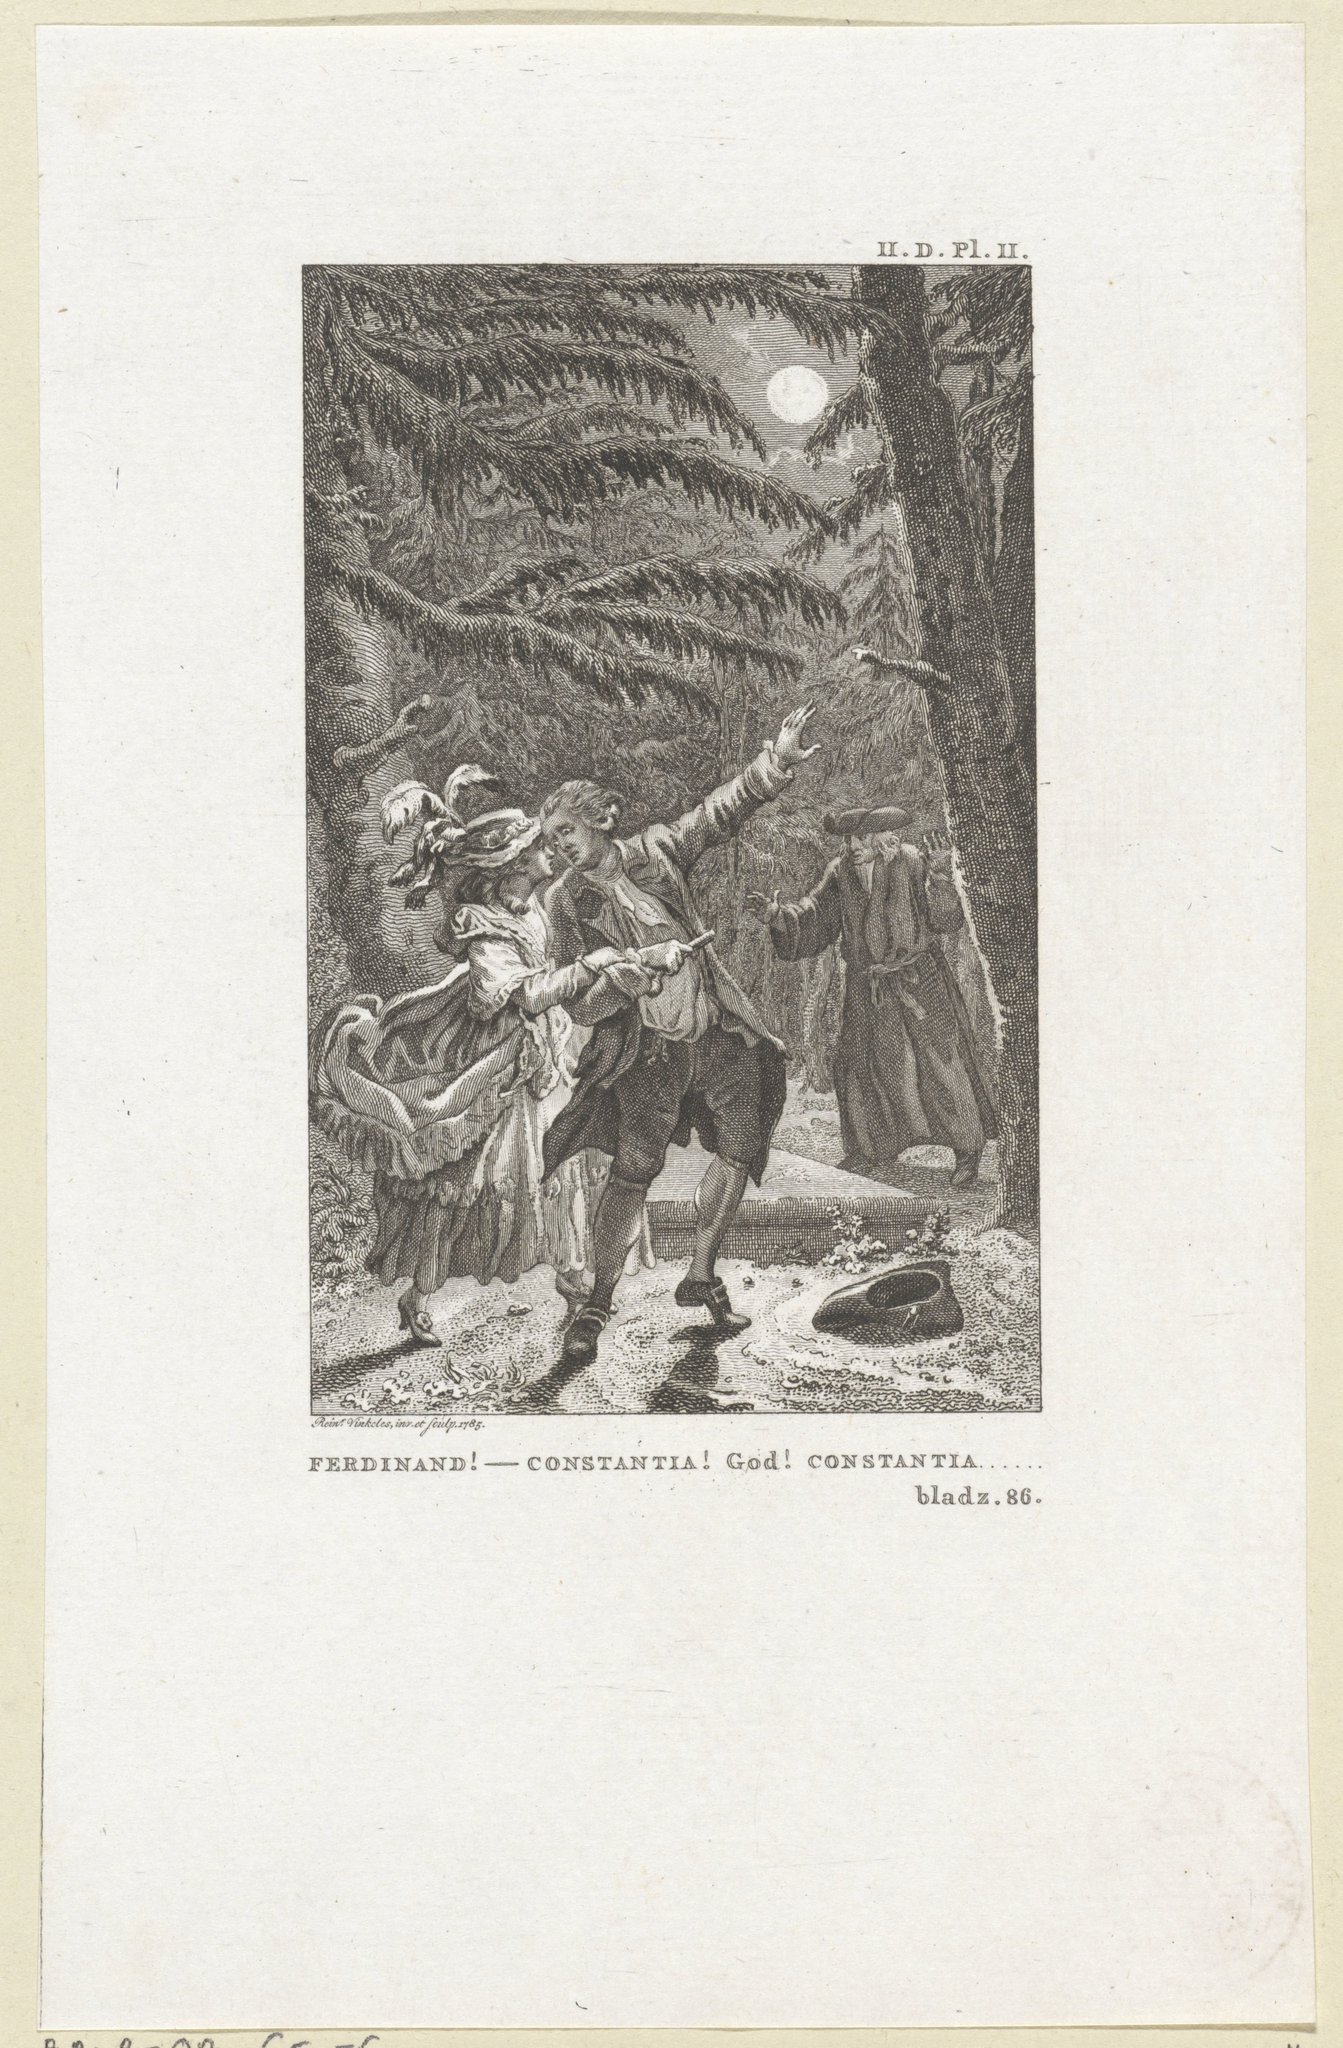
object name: print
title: Nachtgezicht met Ferdinand, Constantia en een tweede man in het bos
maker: reinier vinkeles (i)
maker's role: draughtsman, print maker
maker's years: 1741-1816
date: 1785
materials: paper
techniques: engraving, etching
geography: amsterdam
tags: full moon, forest, wood, night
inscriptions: collector's mark: Lugt 240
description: Deze prent is ook gebruikt als illustratie in: Rhĳnvis, Feith. Ferdinand et Constance. Amsterdam: Johannes Allart, 1785.